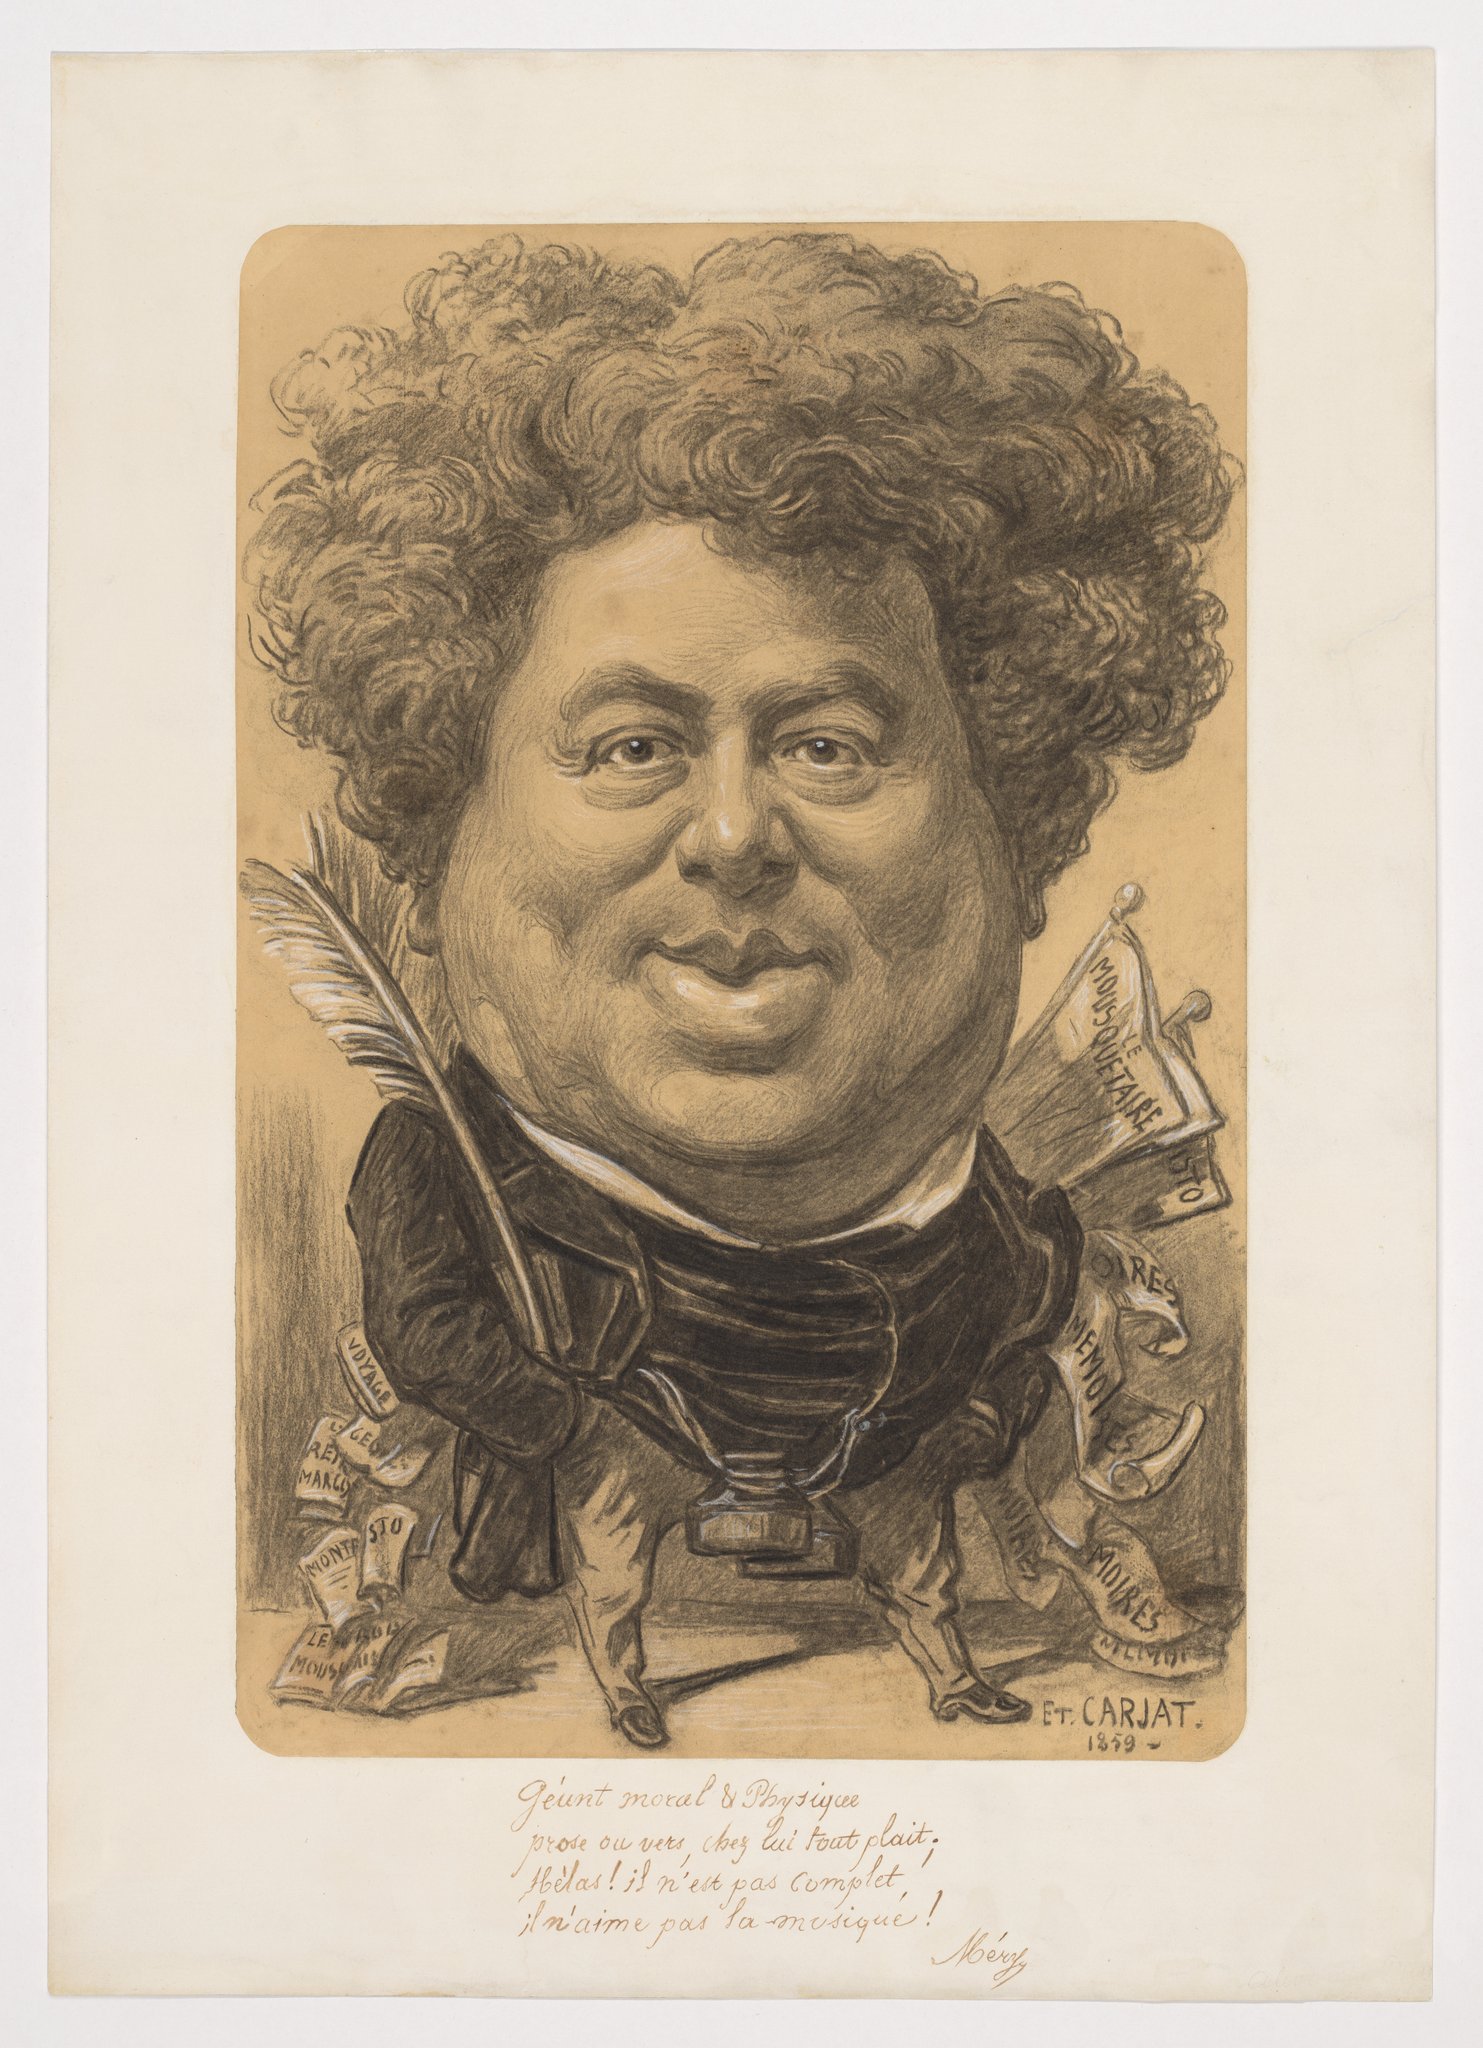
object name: drawing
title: Portrait of Alexandre Dumas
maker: étienne carjat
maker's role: artist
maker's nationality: french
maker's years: 1828-1906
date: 1859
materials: chalk, charcoal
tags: caricature